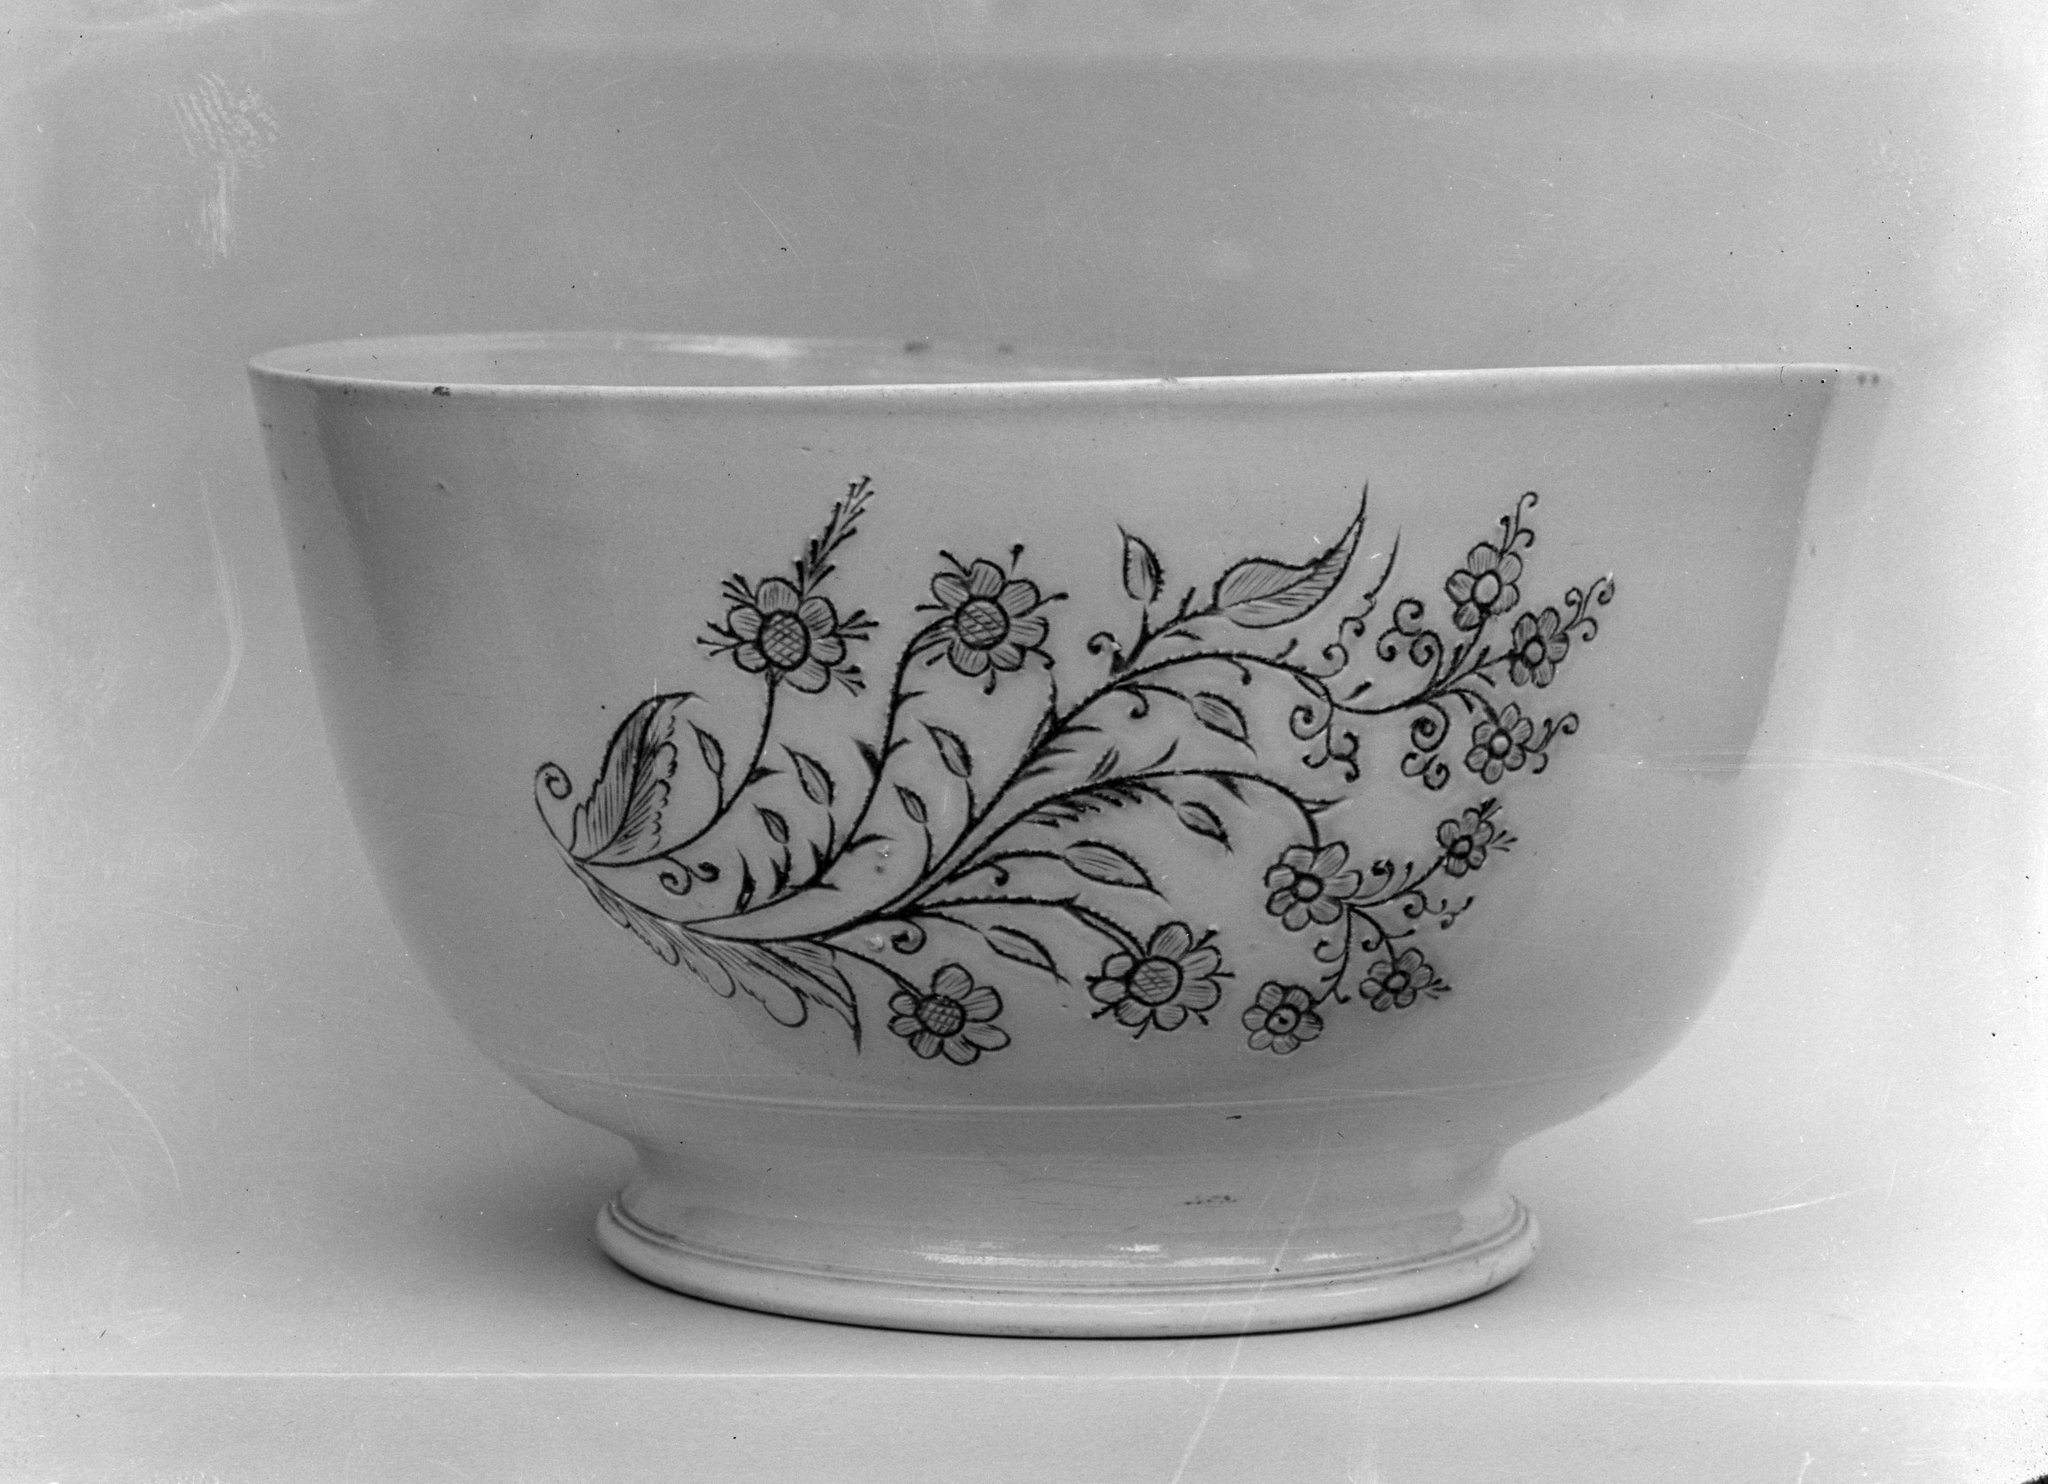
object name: bowl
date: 1750-1760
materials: stoneware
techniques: salt glaze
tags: flowers